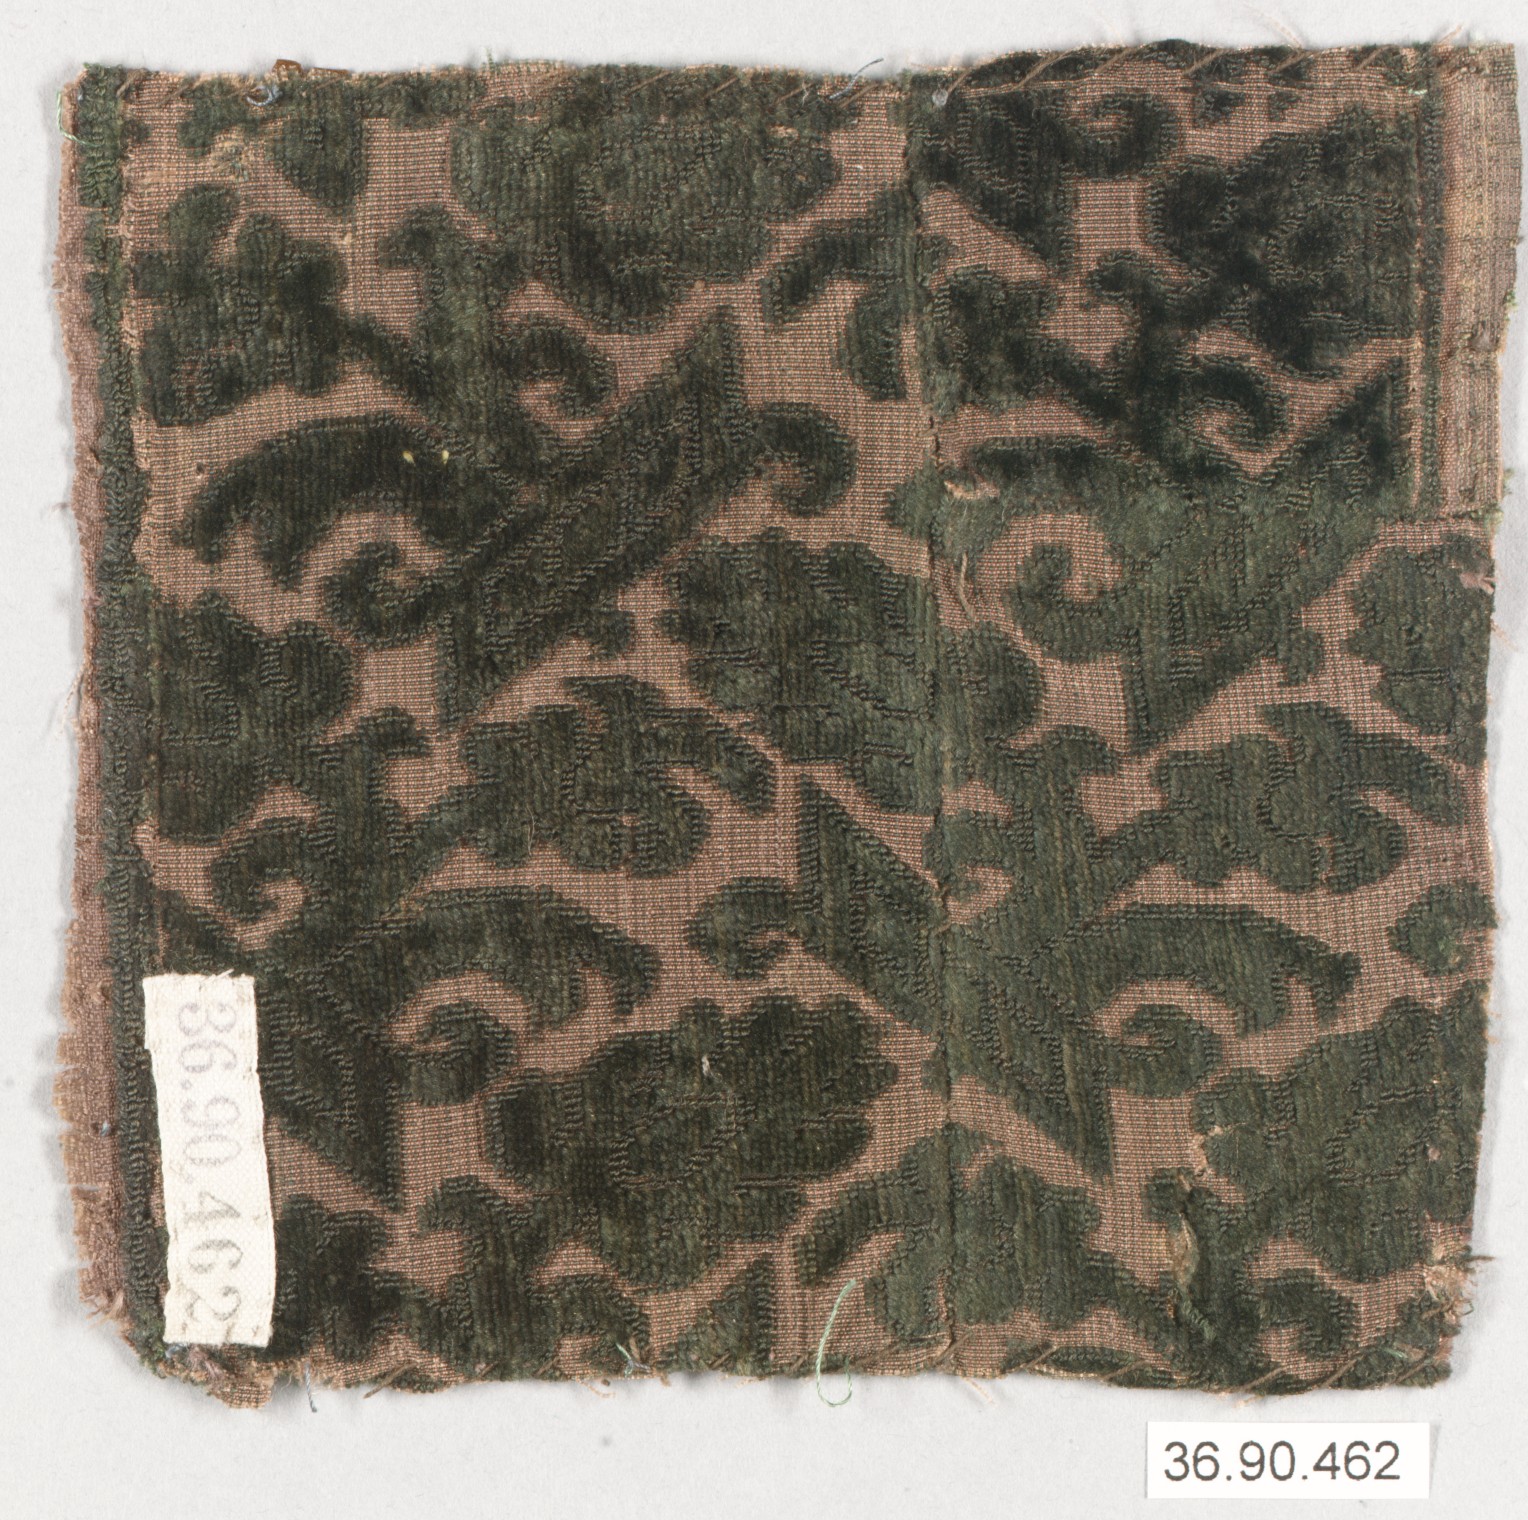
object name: piece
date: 1501-1700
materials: silk